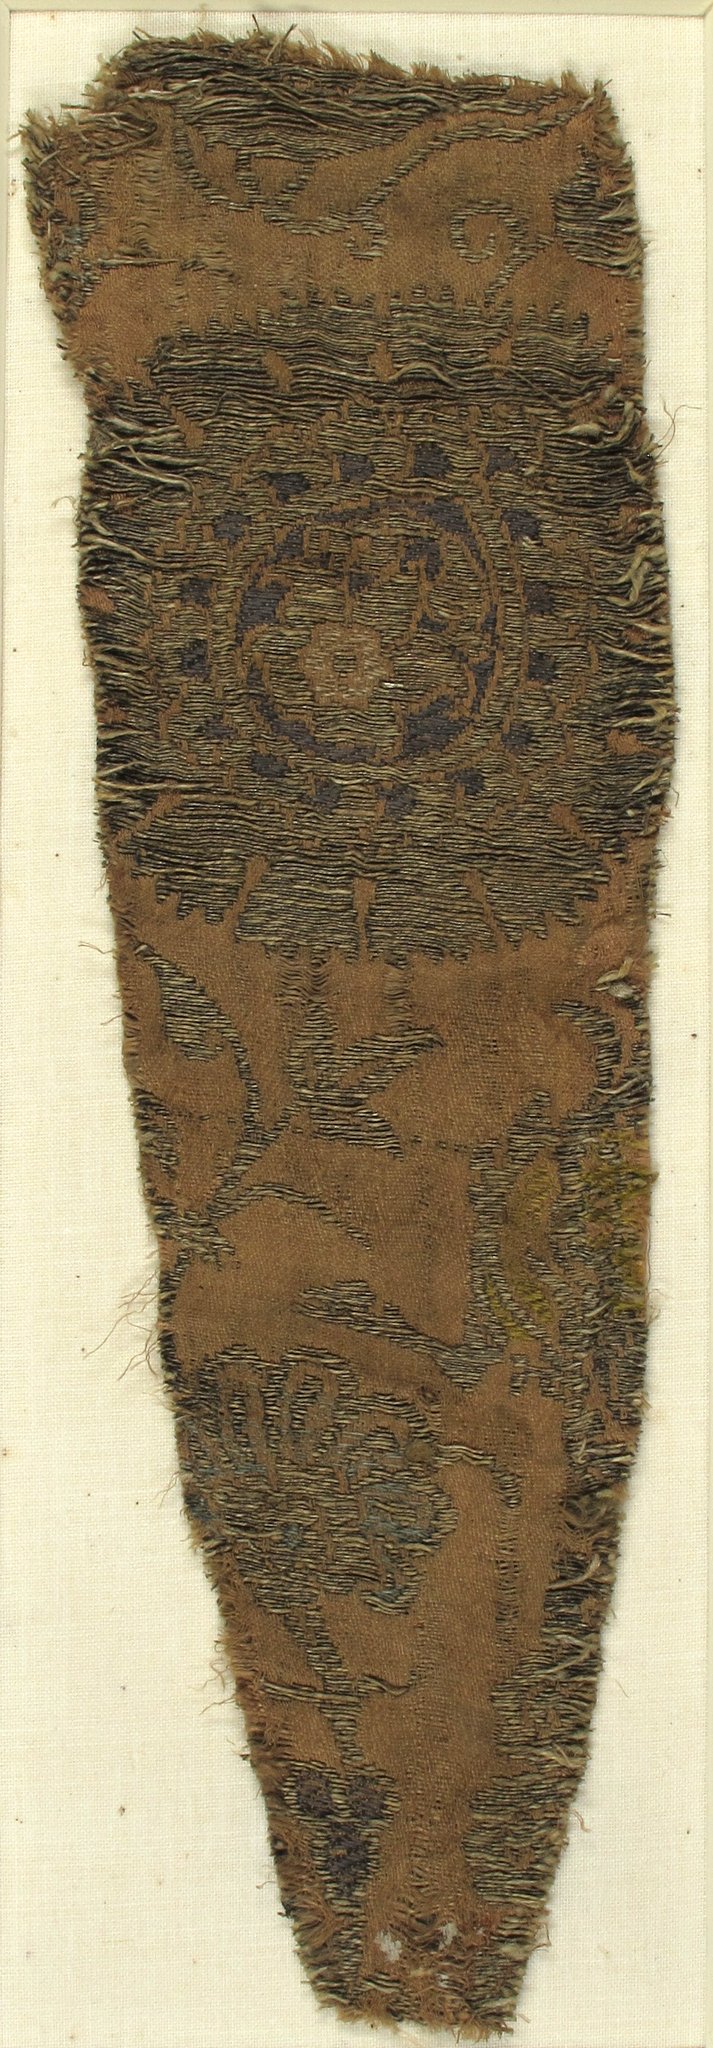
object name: textile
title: Textile with Floral Ornaments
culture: italian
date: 1301-1500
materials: gold, silk